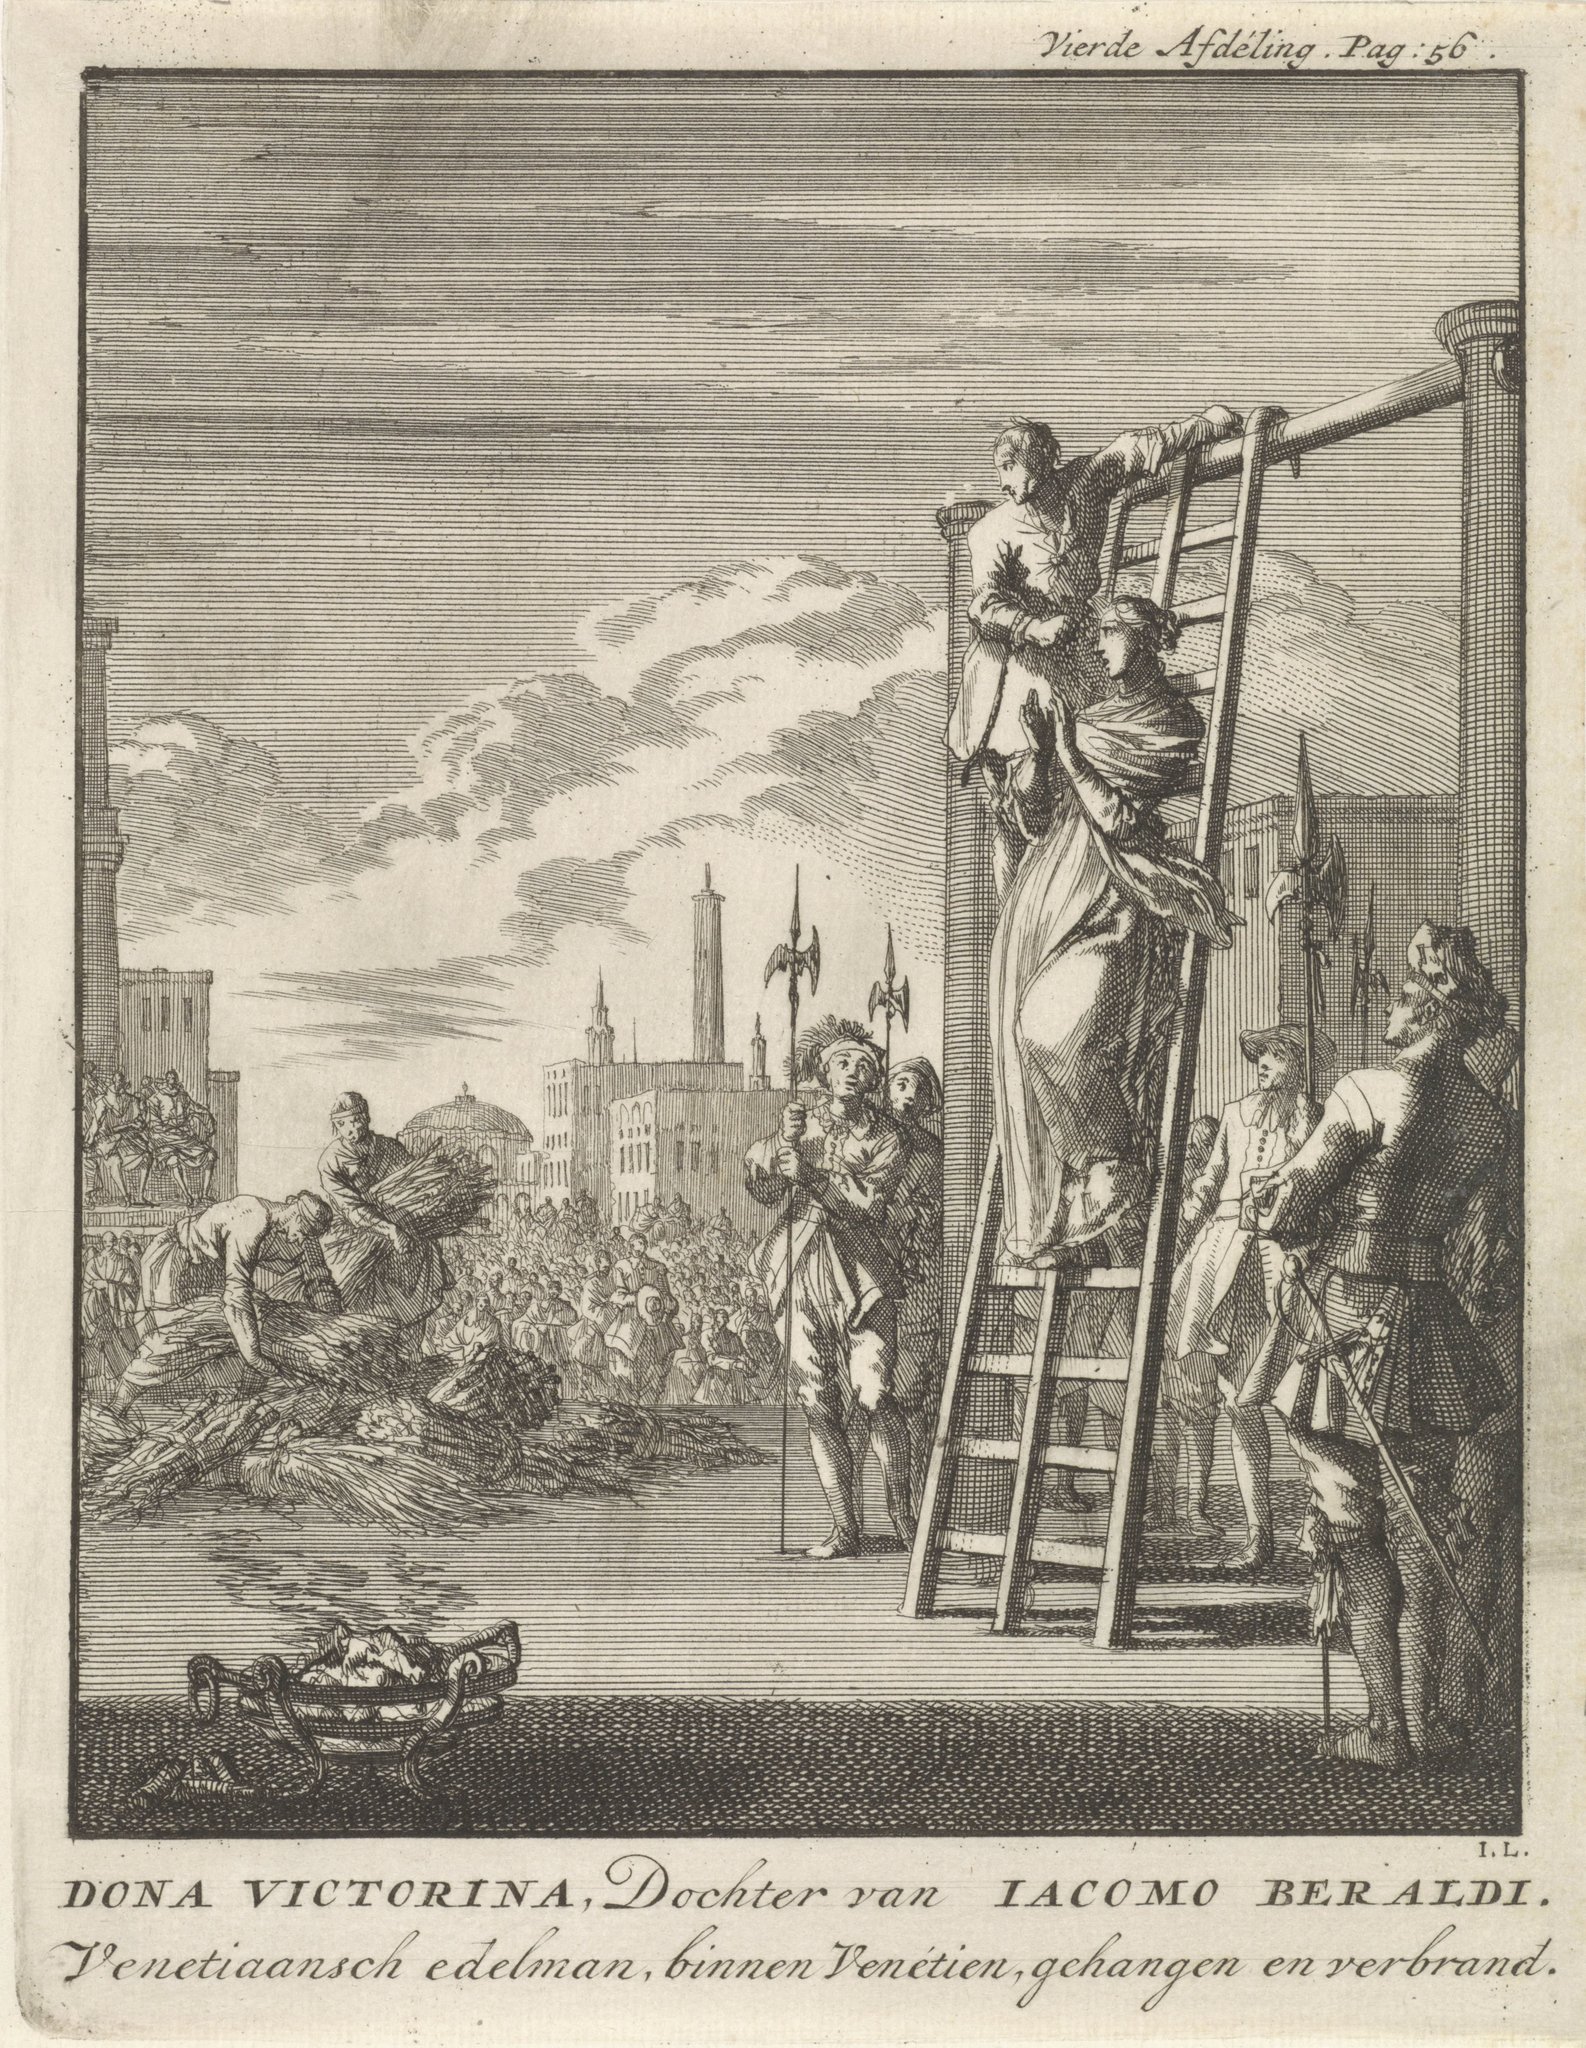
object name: history print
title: Dona Victorina, Dochter van Jacomo Beraldi, Venetiaansch edelman, binnen Venetien, gehangen en verbrand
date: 1699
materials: paper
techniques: etching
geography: amsterdam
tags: violent death by burning at the stake; pyre, on the scaffold or place of execution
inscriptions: collector's mark: Lugt 2228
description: Victorina, de dochter van de edelman Iacomo Beraldi, wordt aan een ladder gebonden om verbrand te worden. Ze wordt terechtgesteld vanwege de moord op haar man, Ludovico Fassino. Op de achtergrond verzamelen de beulen stro en hout voor de brandstapel.